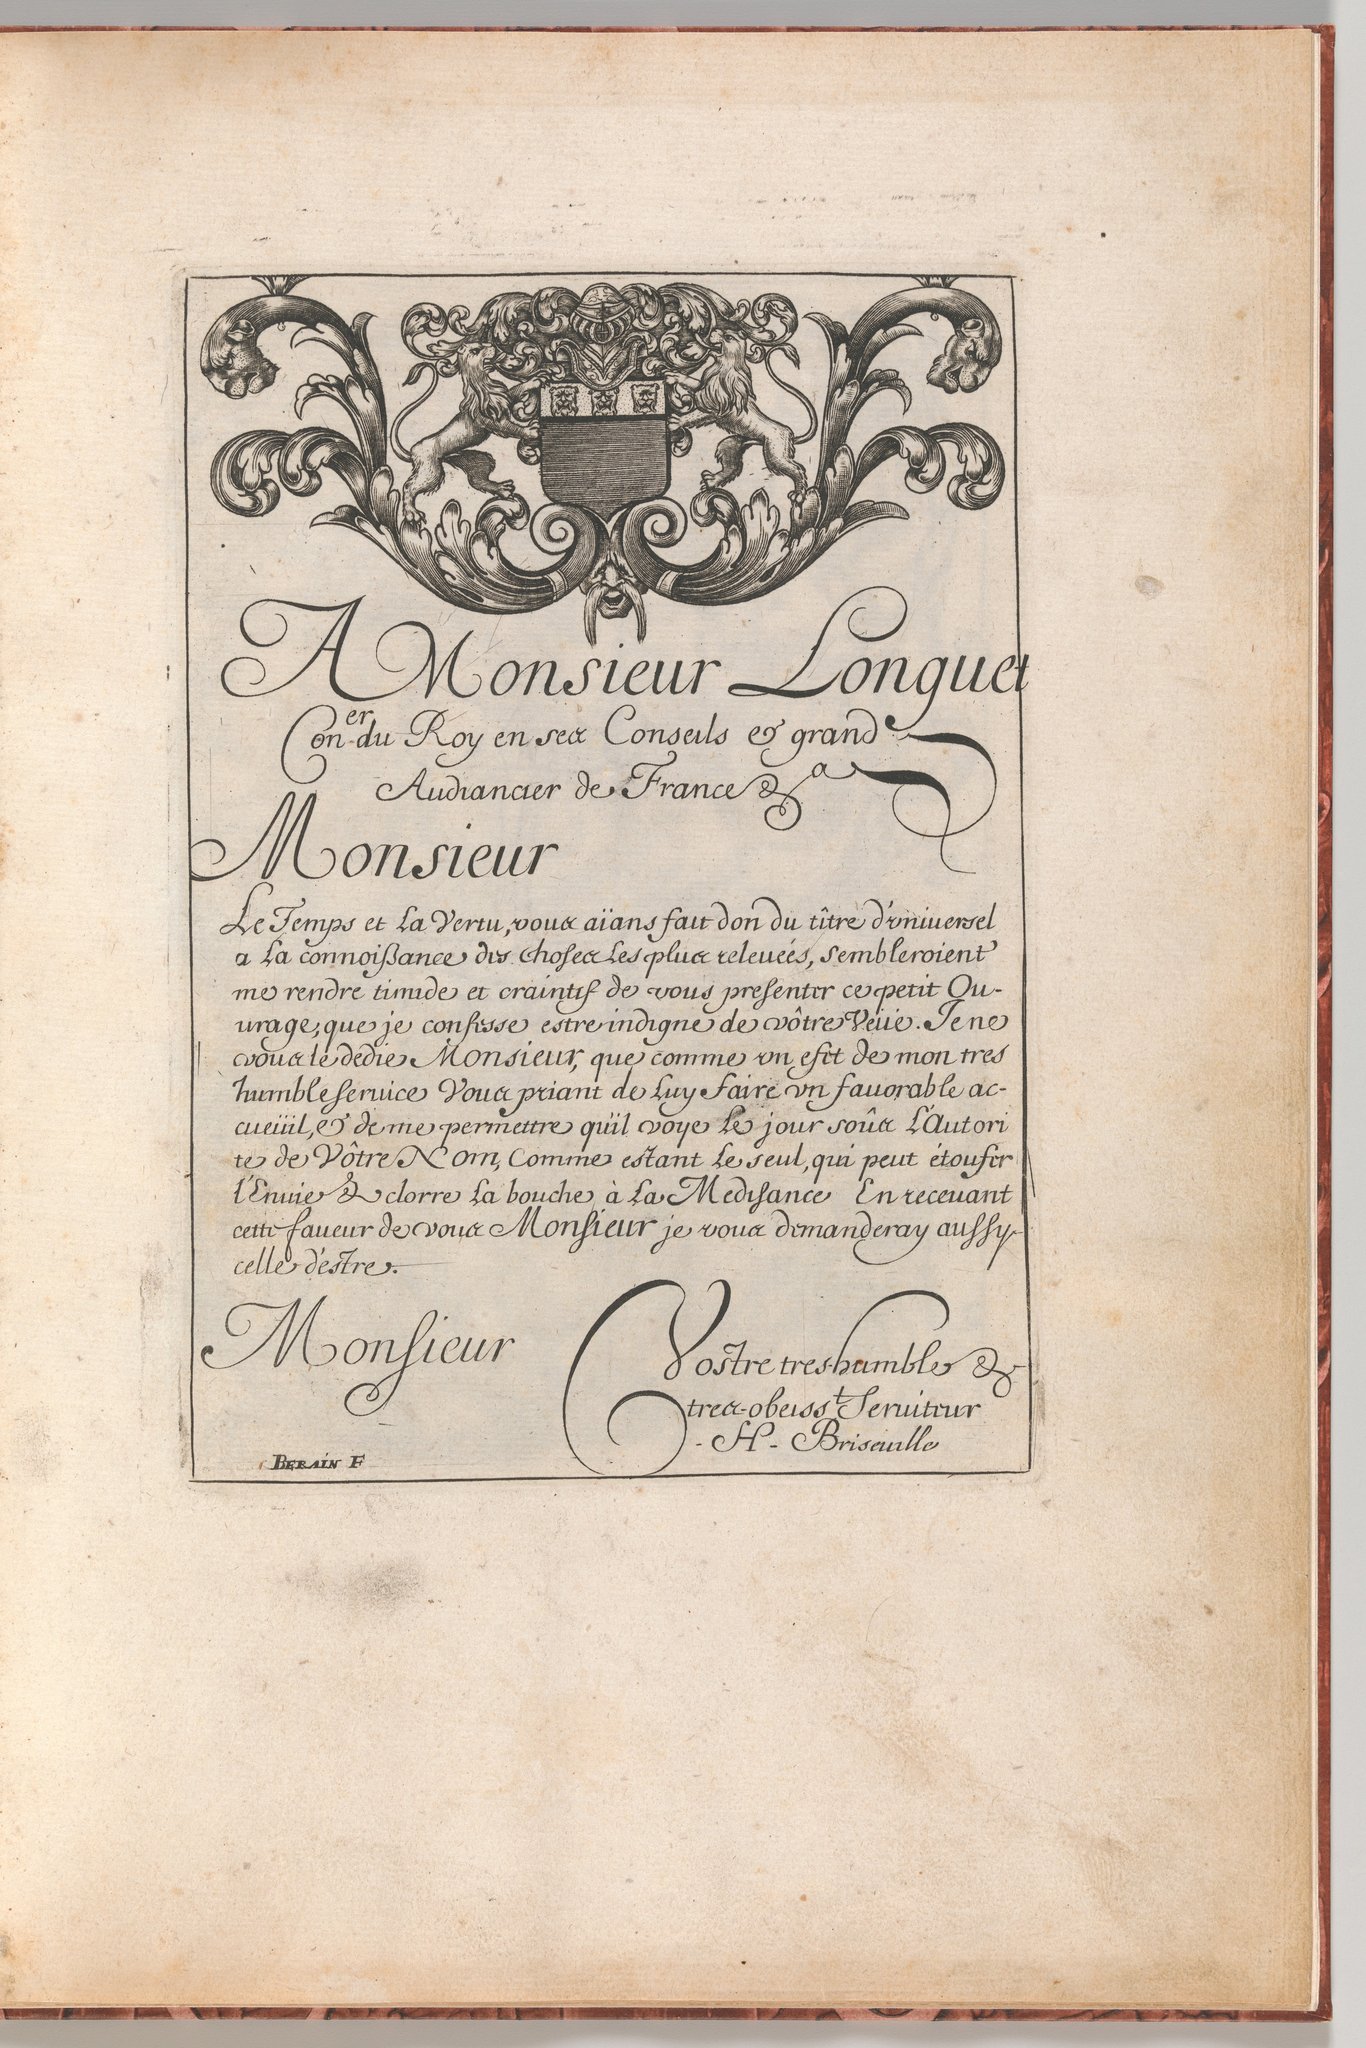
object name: album print ornament architecture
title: Diverses Pieces de Serruriers, page 3 (recto)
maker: jean berain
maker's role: artist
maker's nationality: french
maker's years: 1640-1711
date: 1663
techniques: engraving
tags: ornament,coat of arms